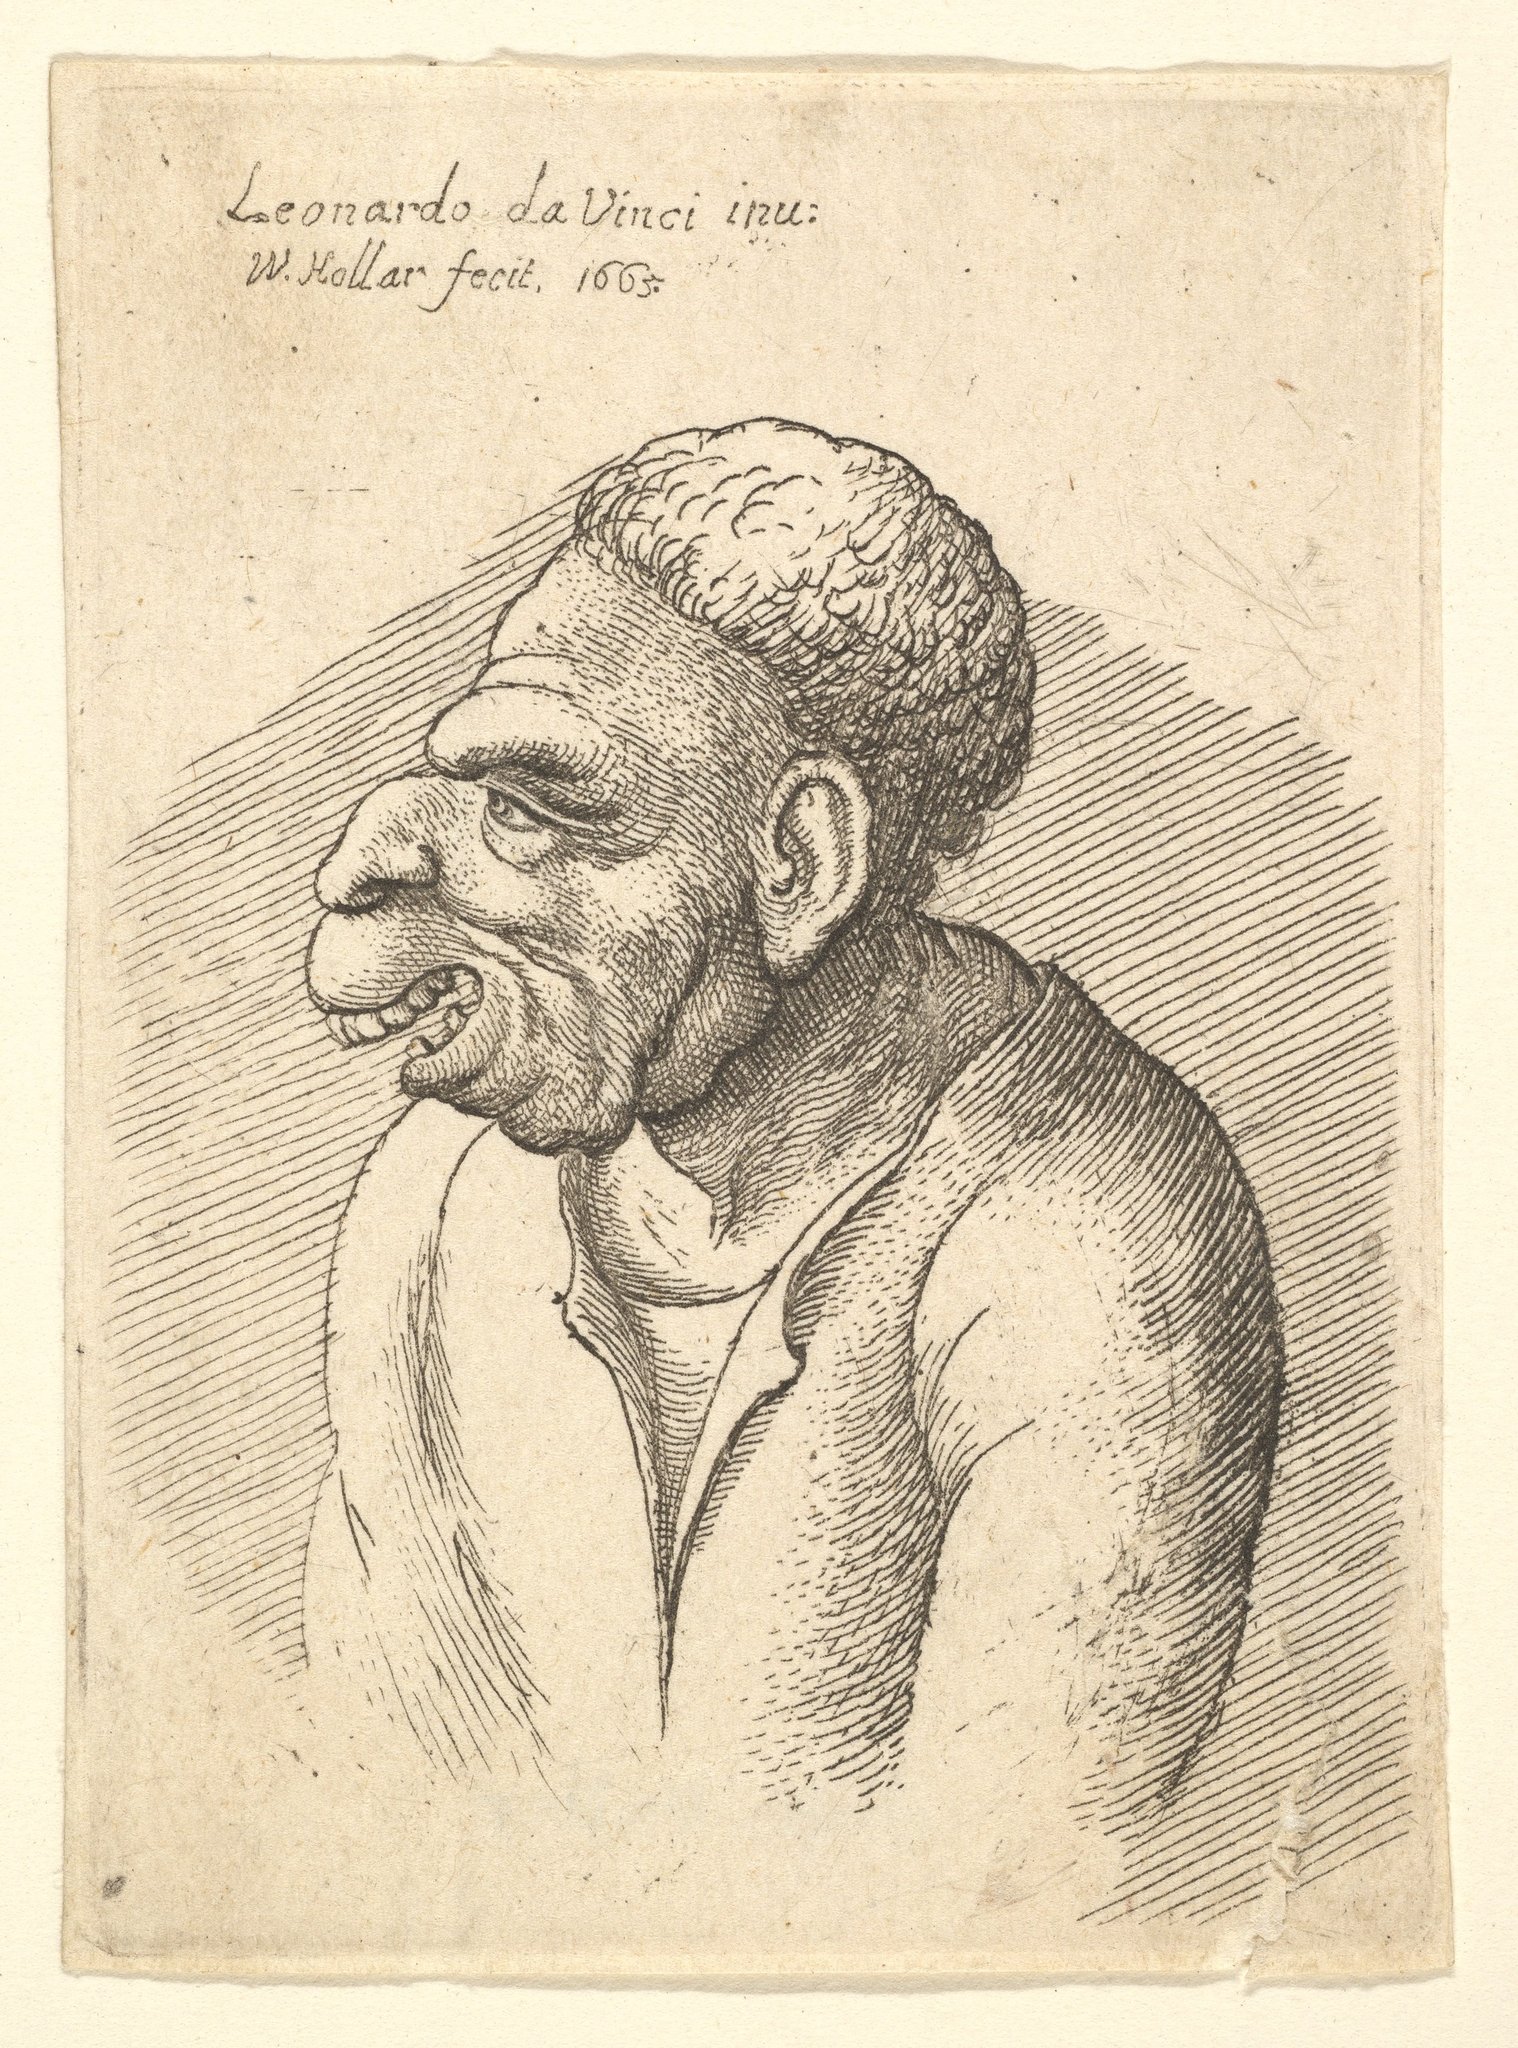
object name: print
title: Bust of a man with hooked nose, prominent upper lip, open mouth and thick, short curly hair resembling wig in profile to left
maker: wenceslaus hollar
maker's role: artist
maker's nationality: bohemian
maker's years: 1607-1677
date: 1665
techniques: etching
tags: men